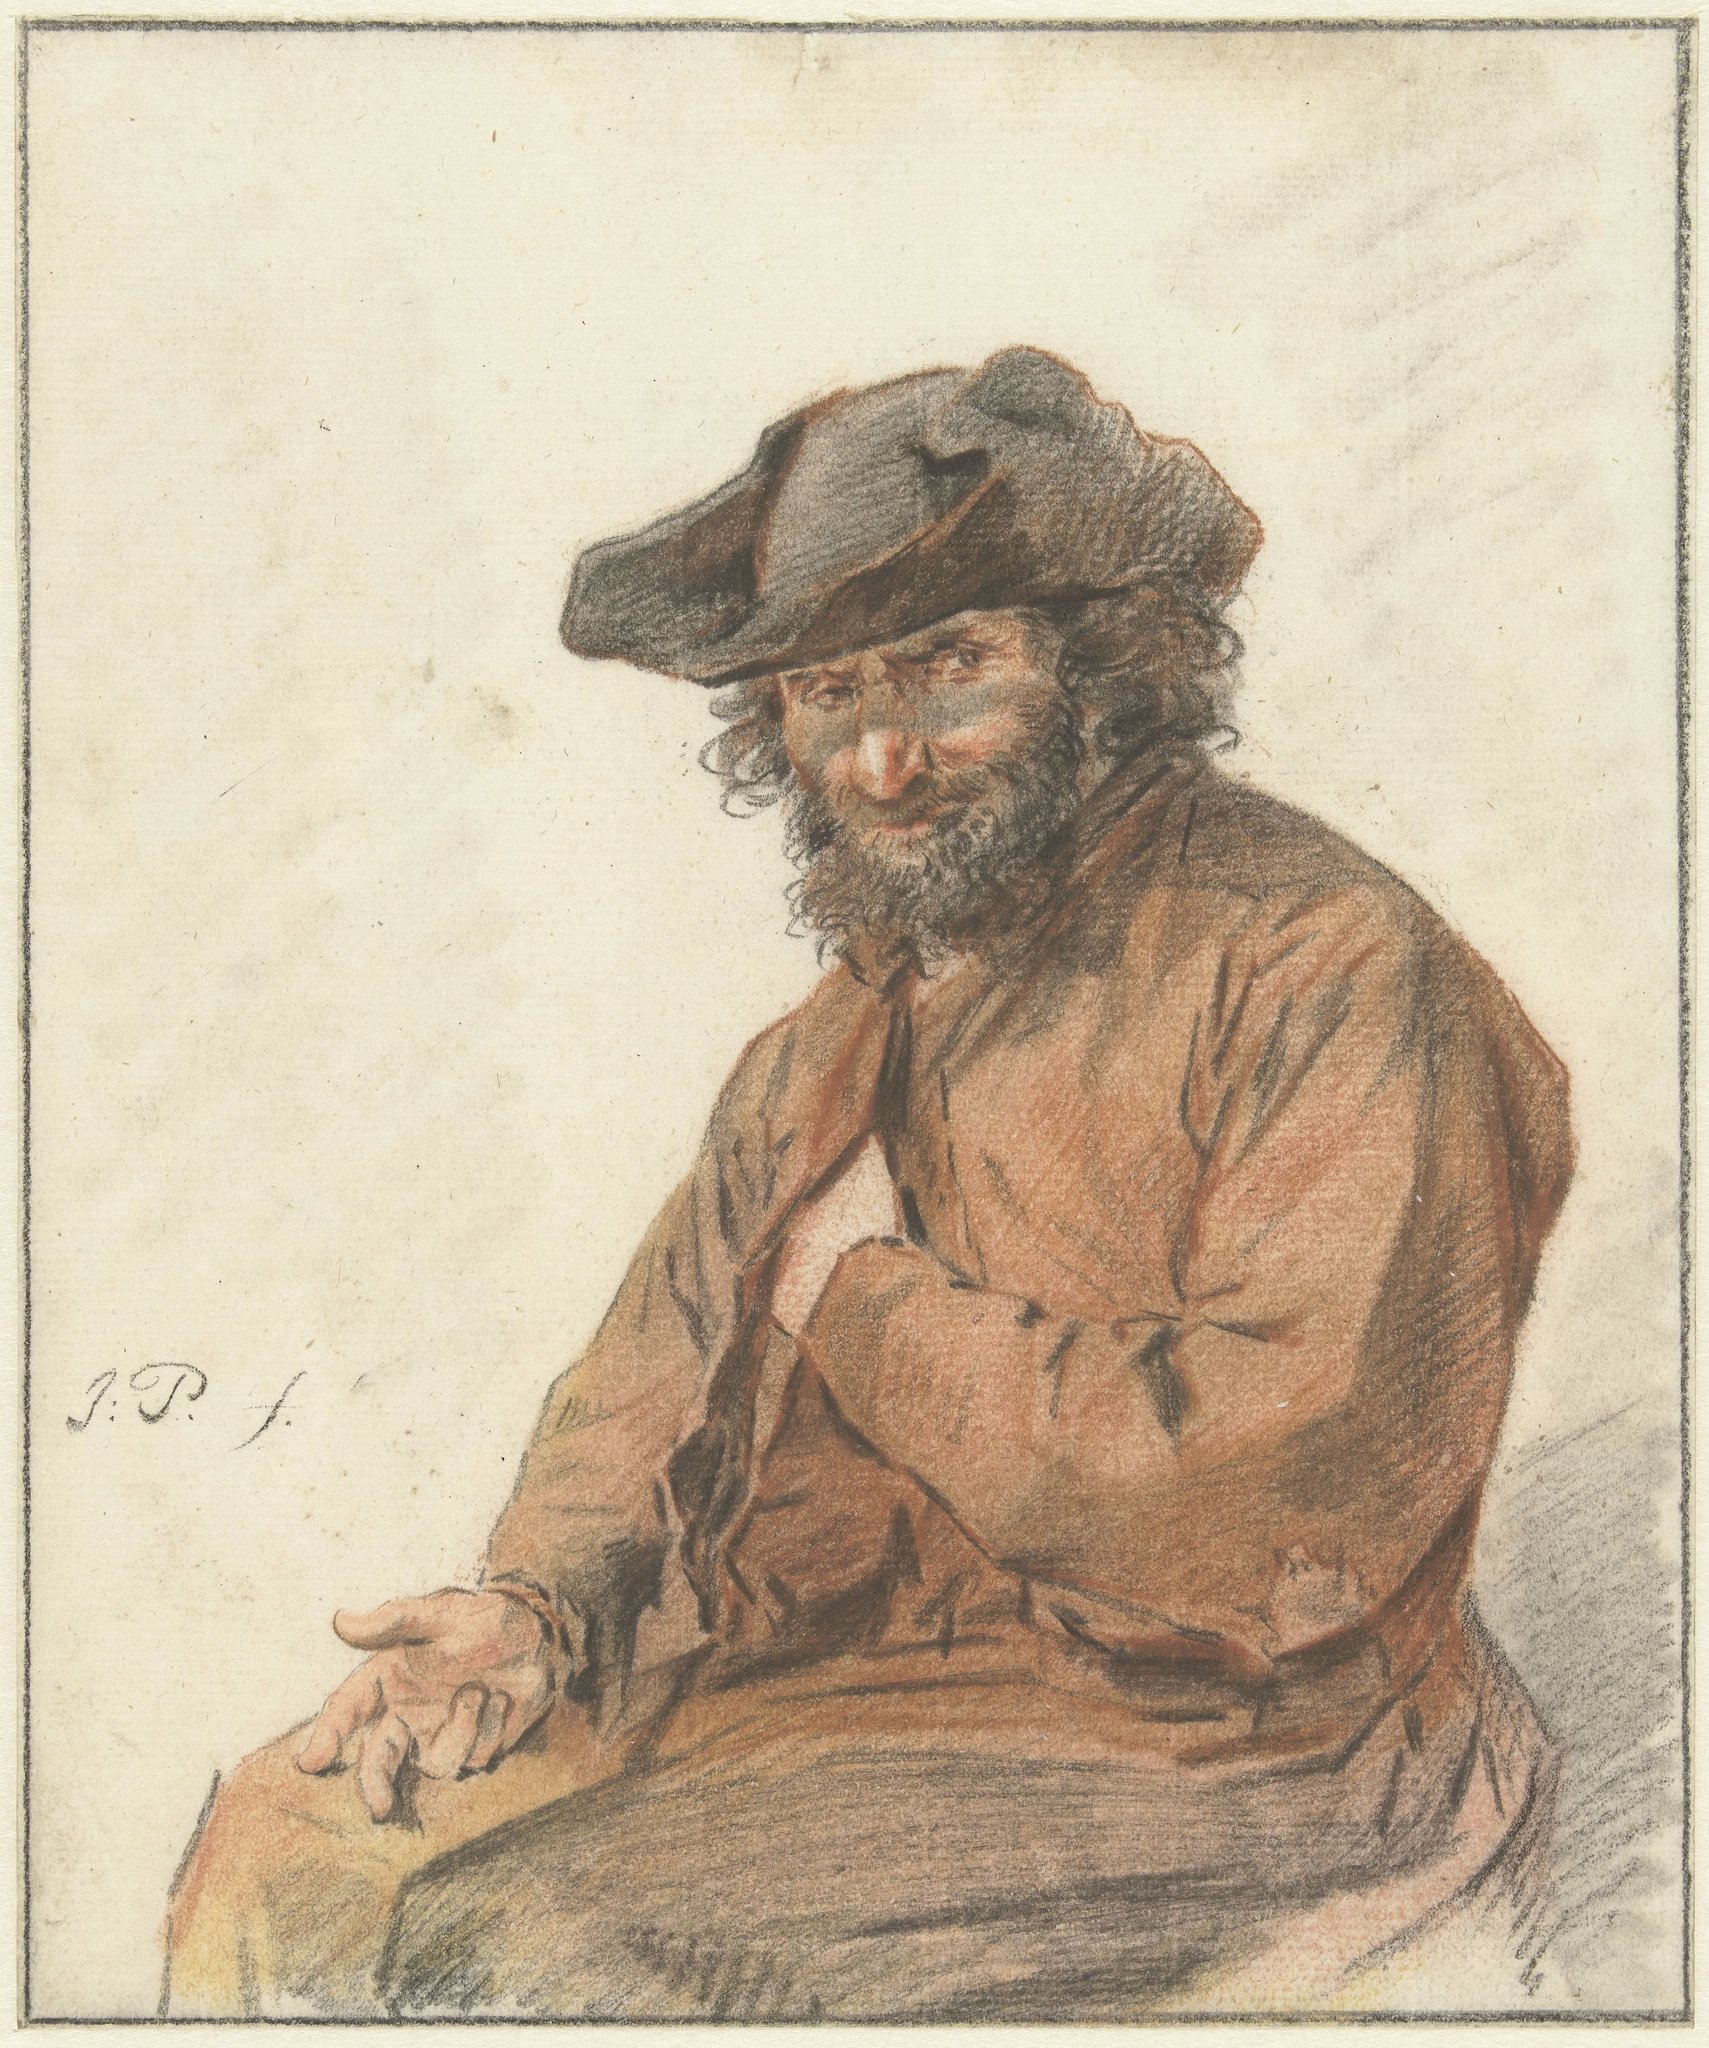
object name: drawing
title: Zittende man met lange krullende haren en zwarte hoed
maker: jacob perkois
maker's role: draughtsman, print maker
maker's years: 1756-1804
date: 1790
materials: chalk, paper